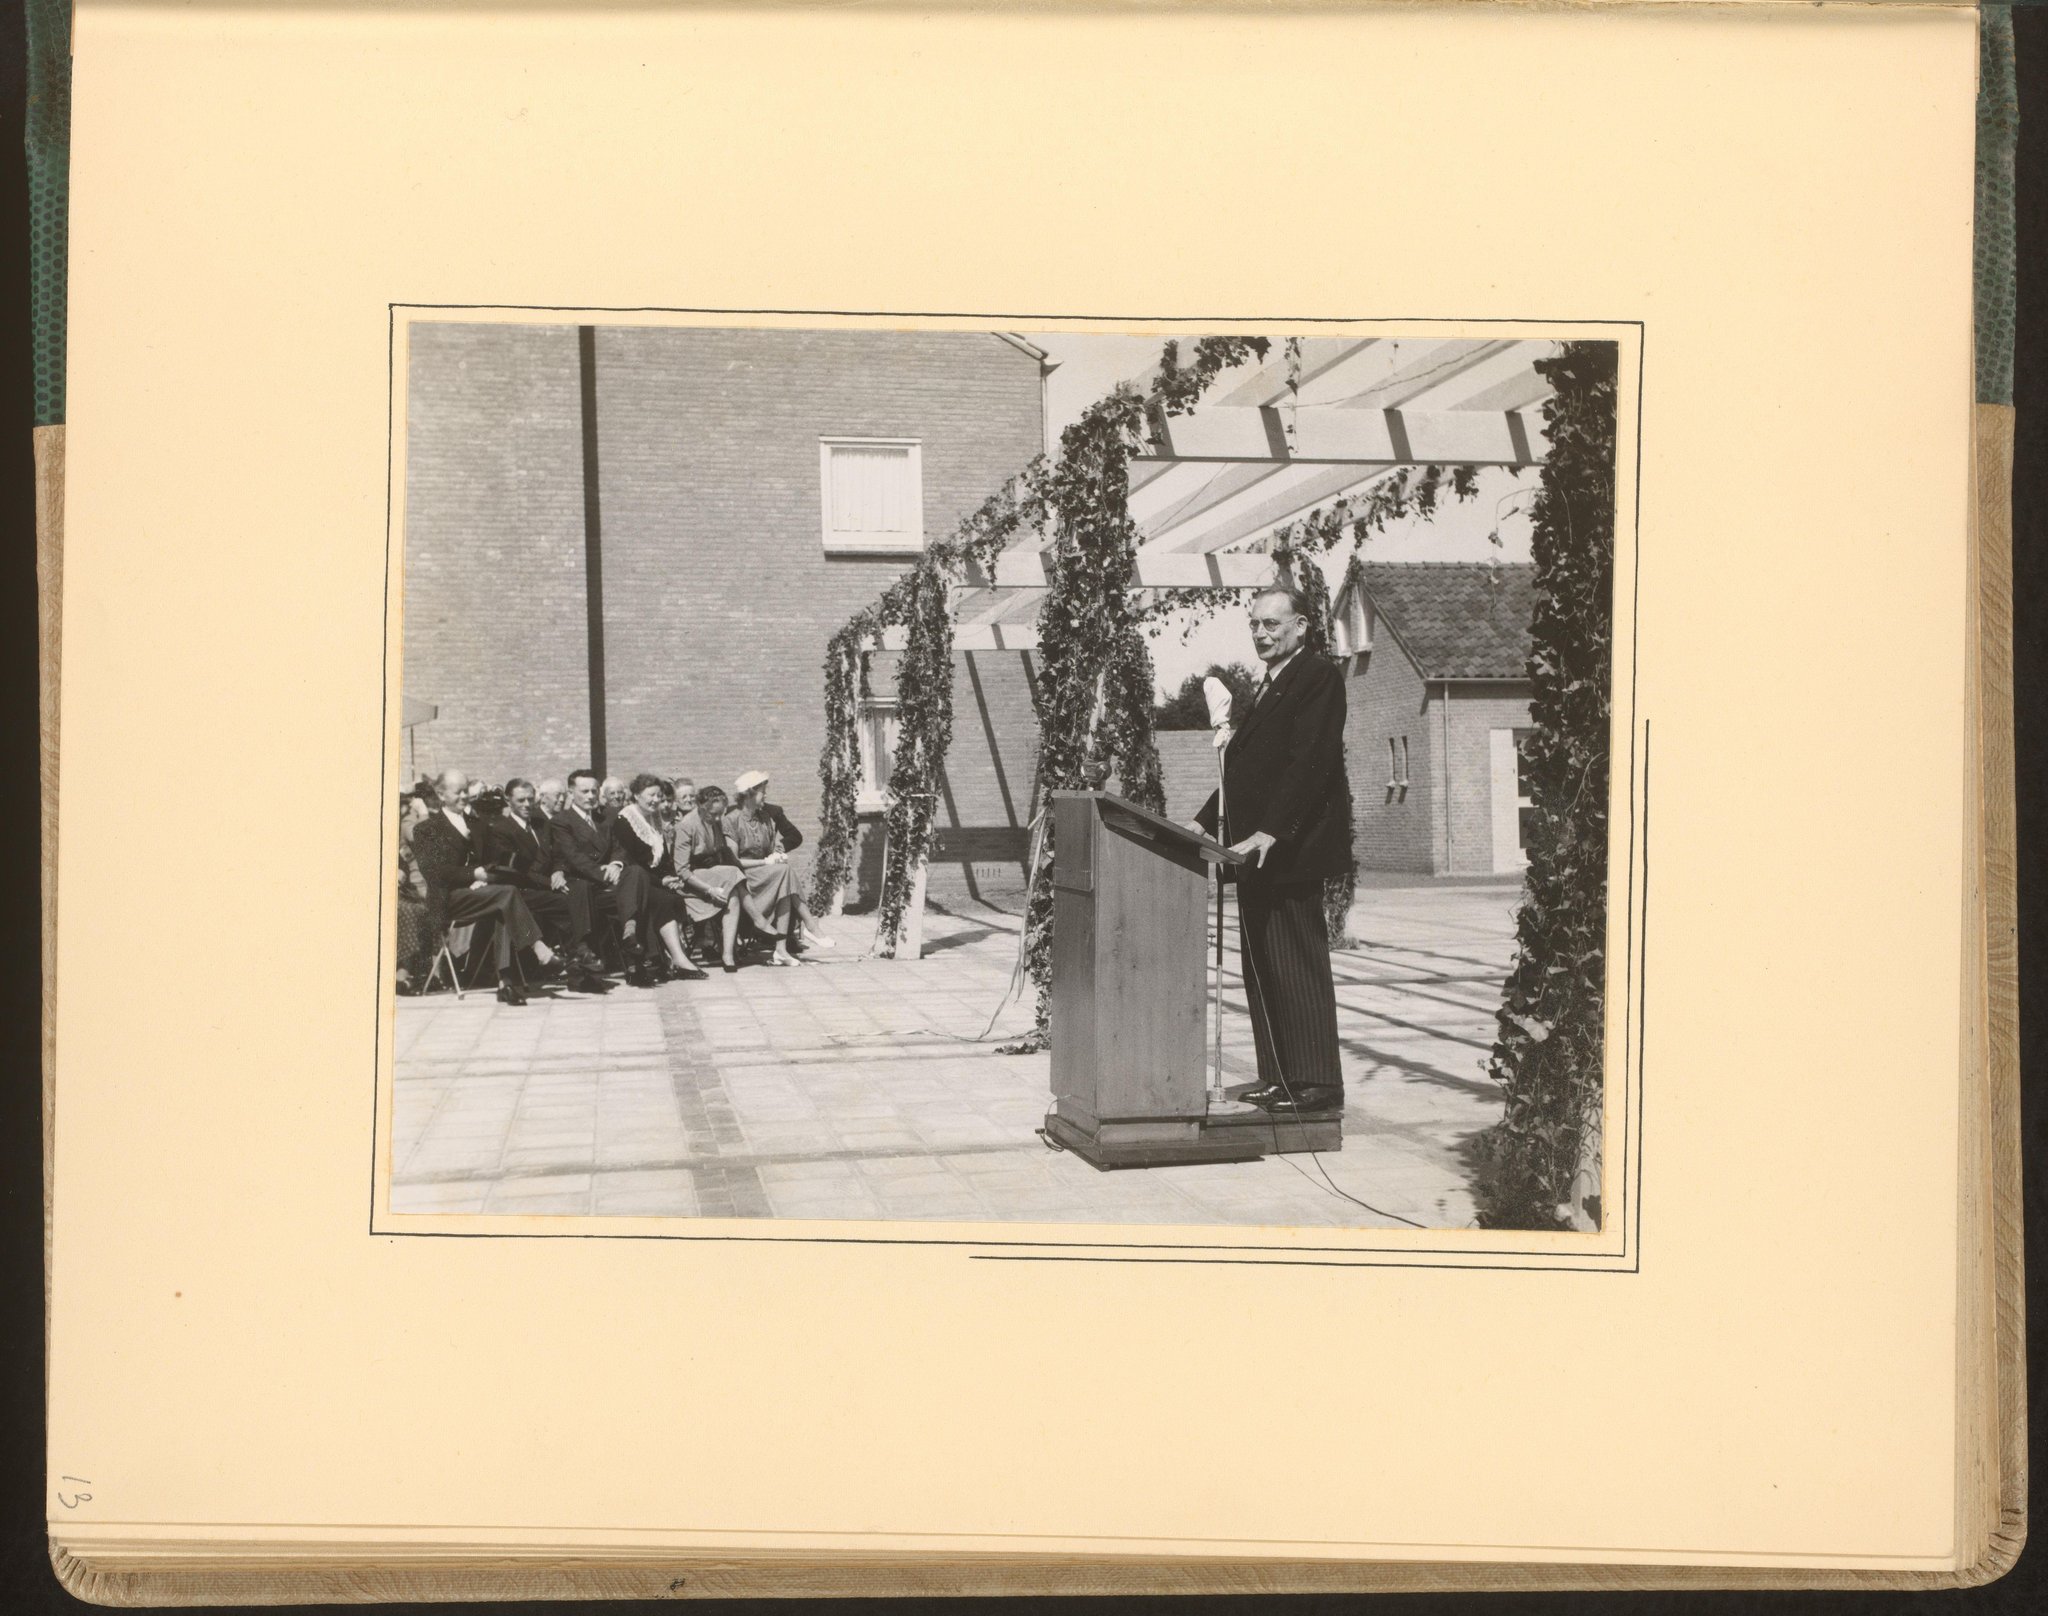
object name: photograph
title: De openingsrede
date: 1953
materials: paper, photographic support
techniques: gelatin silver print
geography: lochem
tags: willem drees, prime minister, activities in the air ~ public festivities, e.g. fly-past, old-people's home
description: Premier Willem Drees houdt een rede ter ere van de opening van het bejaardenhuis. Onderdeel van het fotoalbum over de opening van bejaardenhuis De Berkelhof in Lochem door Dr. W. Drees op 8 augustus 1953